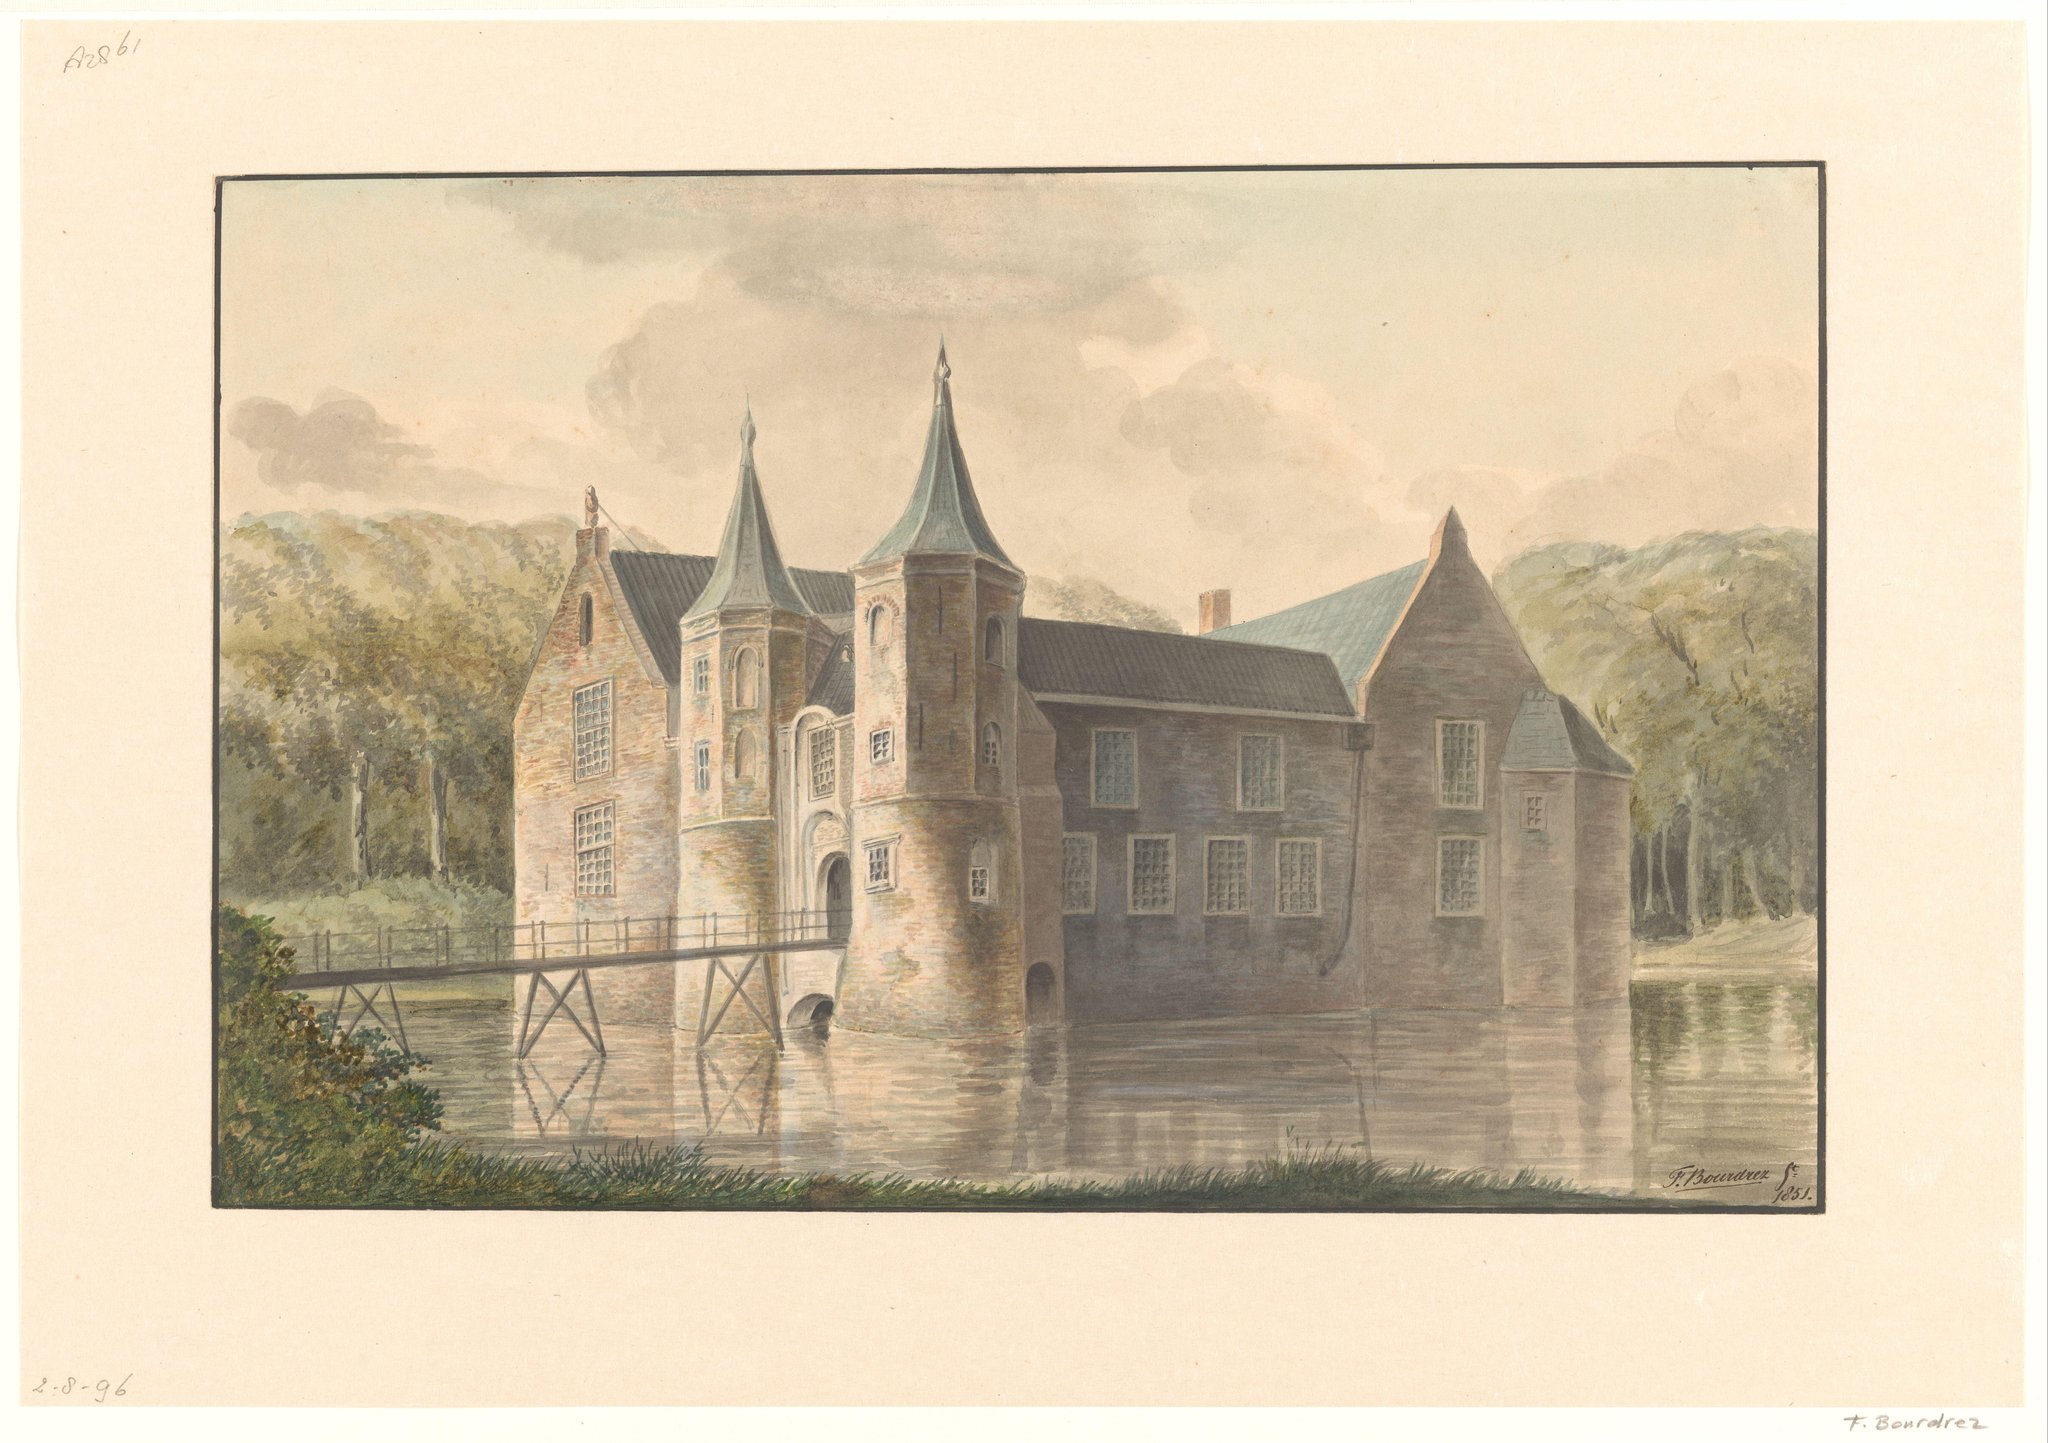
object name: drawing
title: Kasteel Popkensburg op Walcheren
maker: f. bourdrez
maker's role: draughtsman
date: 1851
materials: paper, pencil, watercolor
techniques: brush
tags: city-view, and landscape with man-made constructions, castle